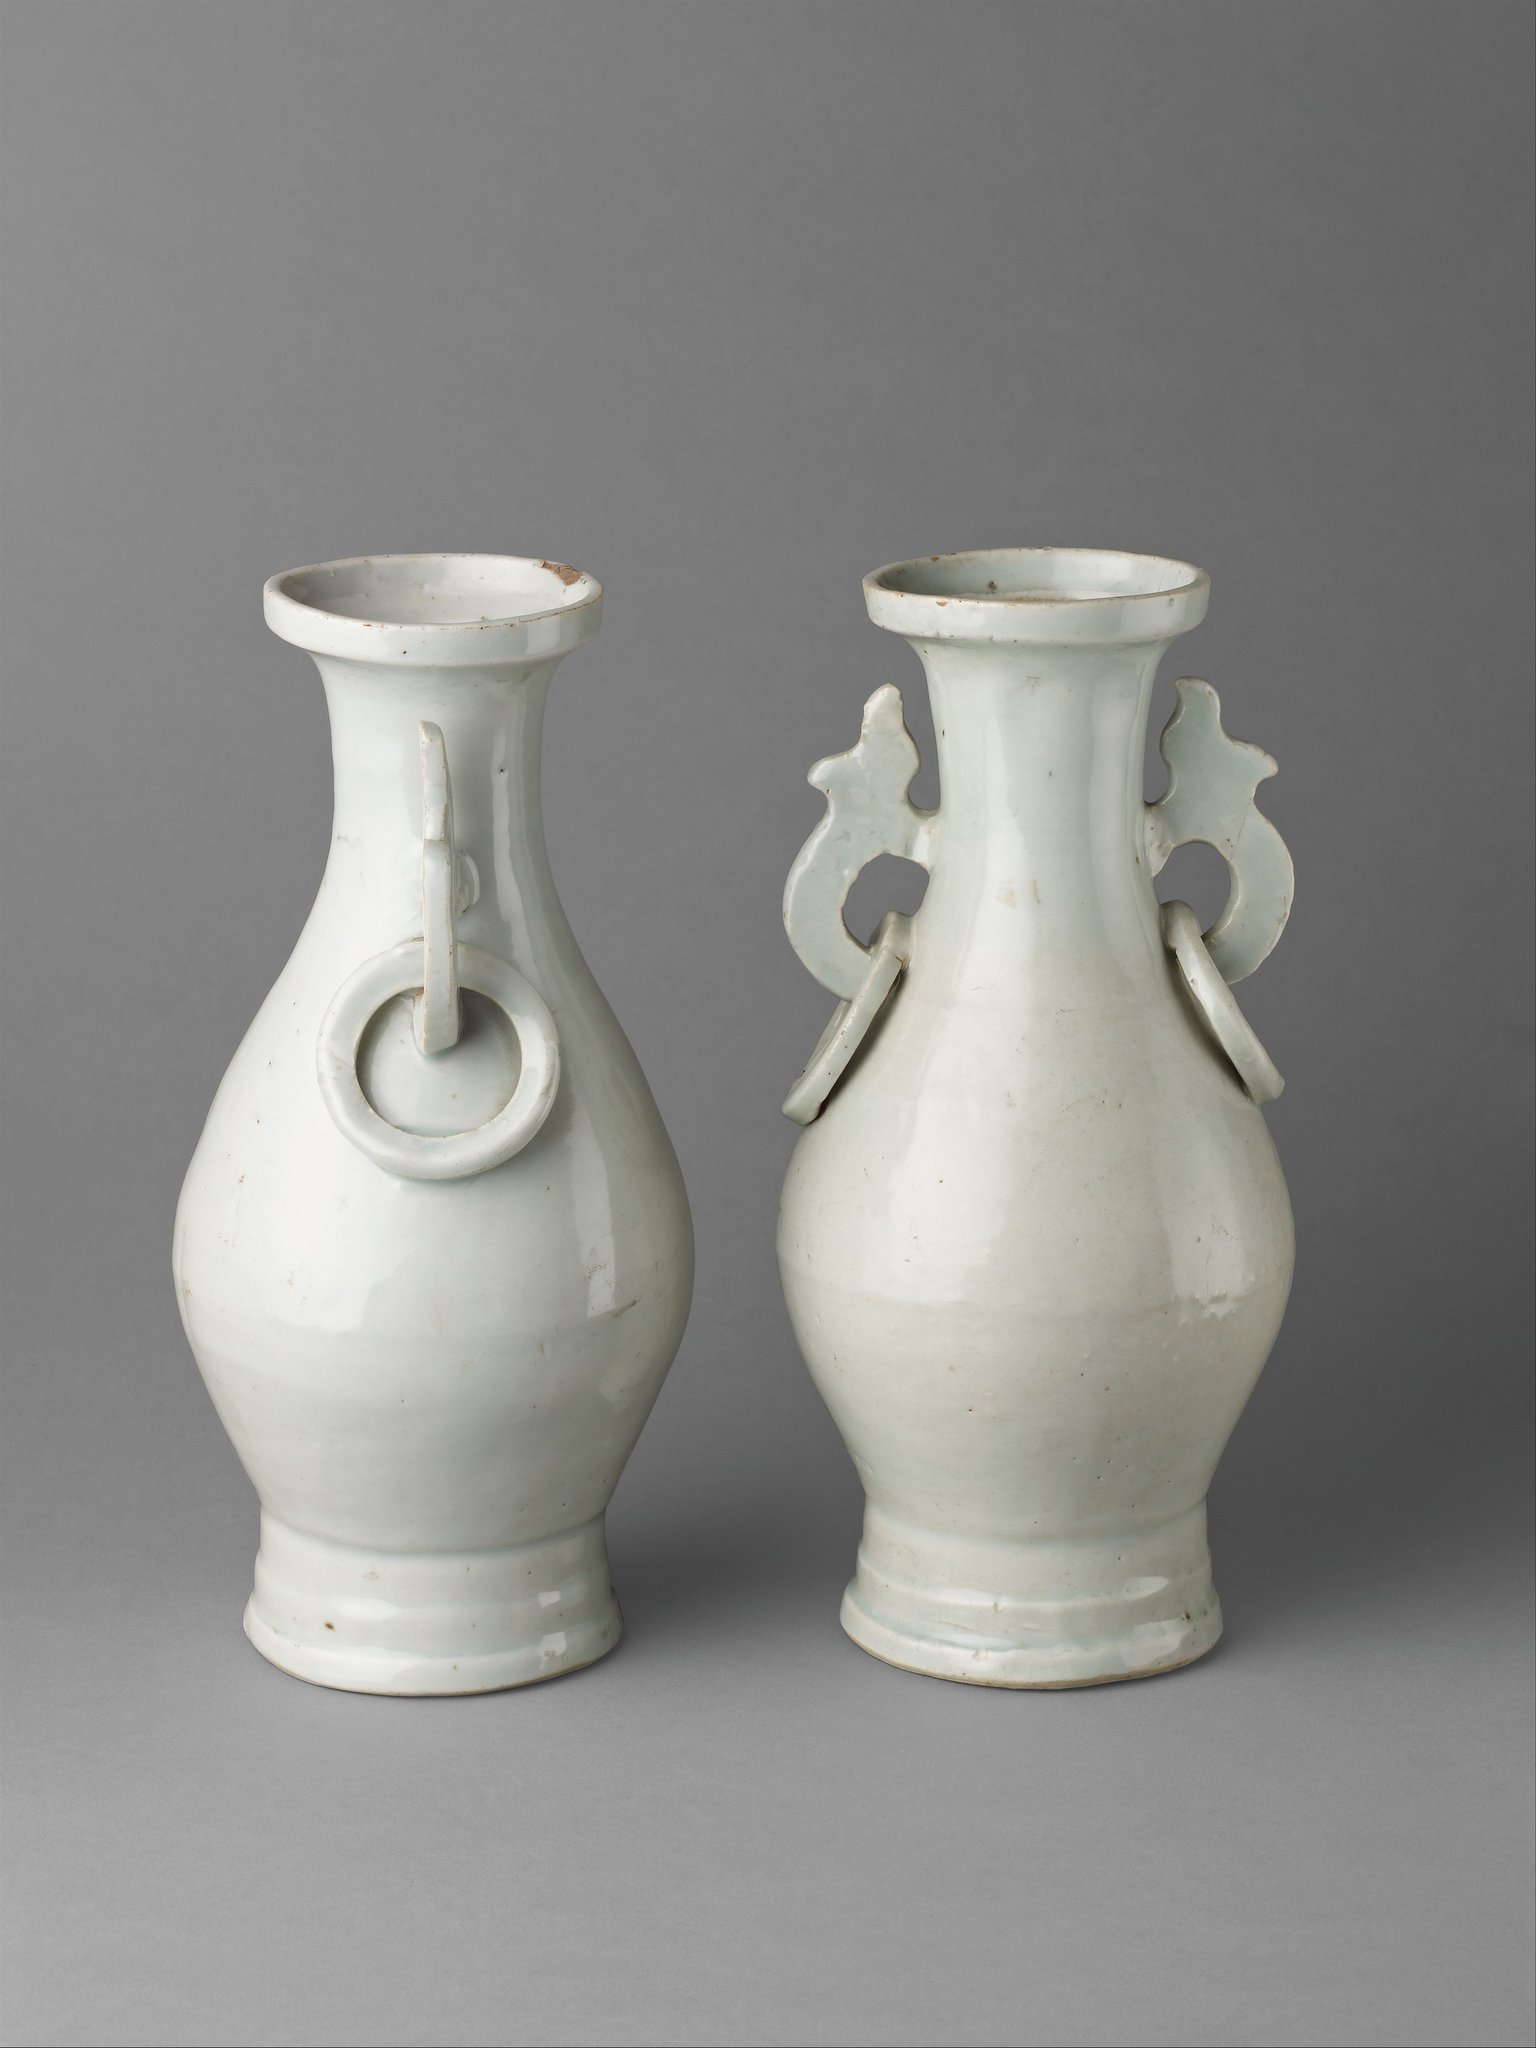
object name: vase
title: Vase: Qingbai Shufu-type ware (pair with 1975.1.1670)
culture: chinese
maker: chinese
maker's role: artist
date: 1301-1400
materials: glaze, porcelain